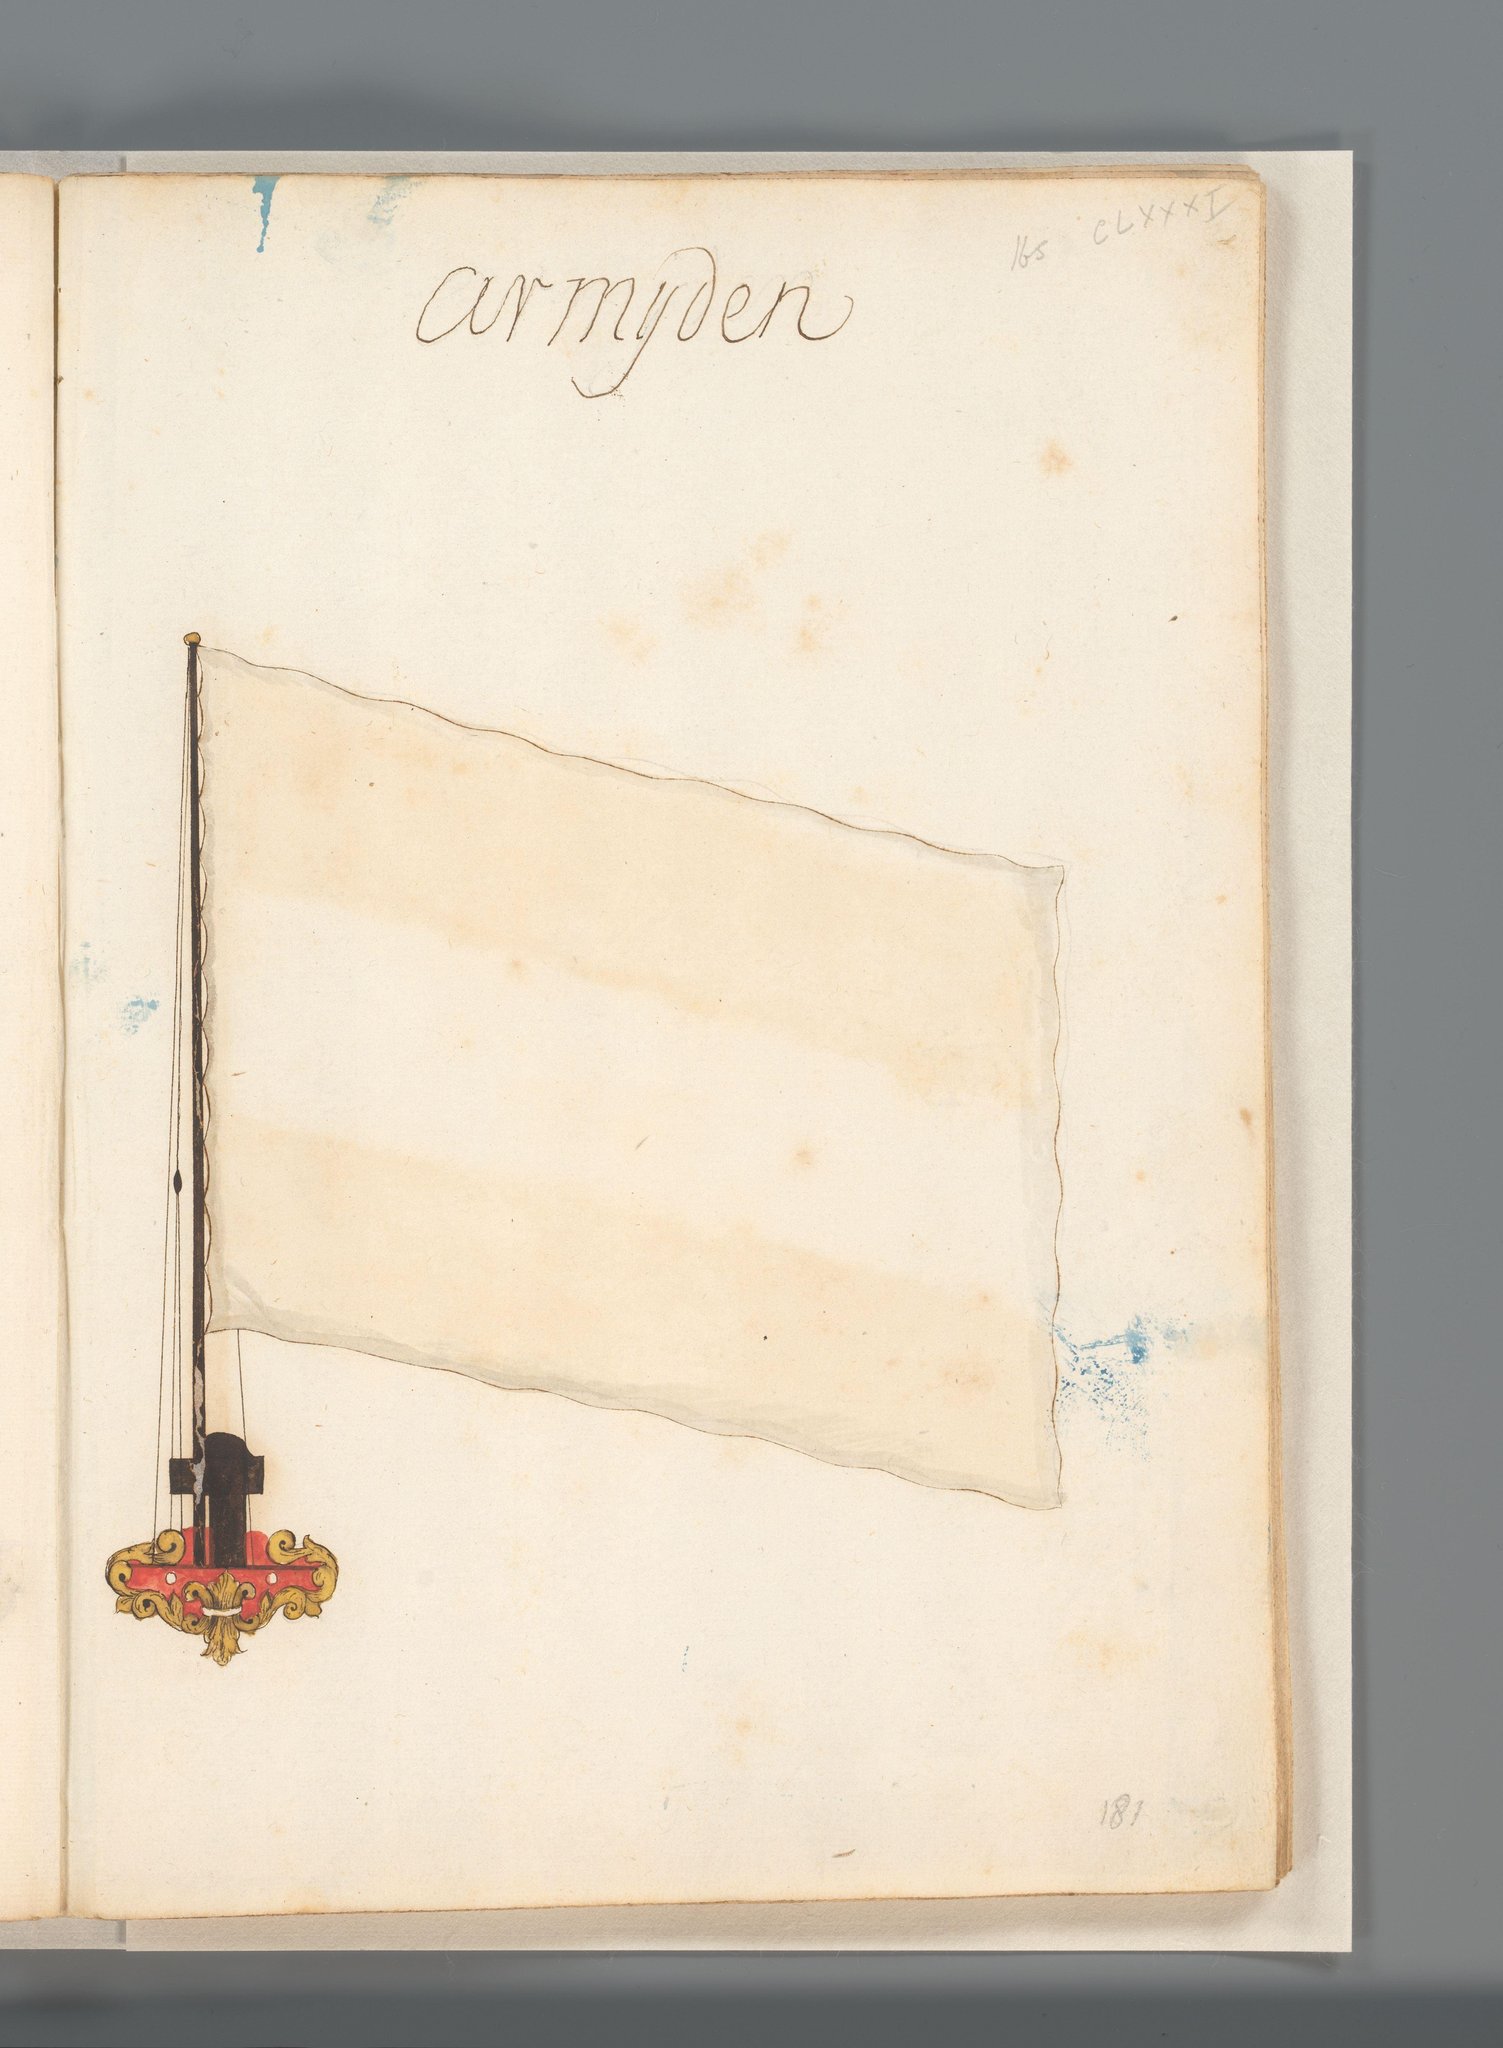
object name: drawing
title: Vlag van Arnemuiden (blanco)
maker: Anonymous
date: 1667-1670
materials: ink, paper, watercolor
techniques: brush, pen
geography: france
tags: flag, colours (as symbol of the state, etc.)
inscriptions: number: ‘165 / CLXXXI / 181’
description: Blanco, oningevulde vlag, bestemd voor de vlag van de plaats Arnemuiden. Vlag op vlaggensteng en mastvoet. Afgebeeld op folio 91r. Onderdeel van een vlaggenboek met vlaggen uit Europa, Noord-Afrika, Nabije en Verre Oosten.